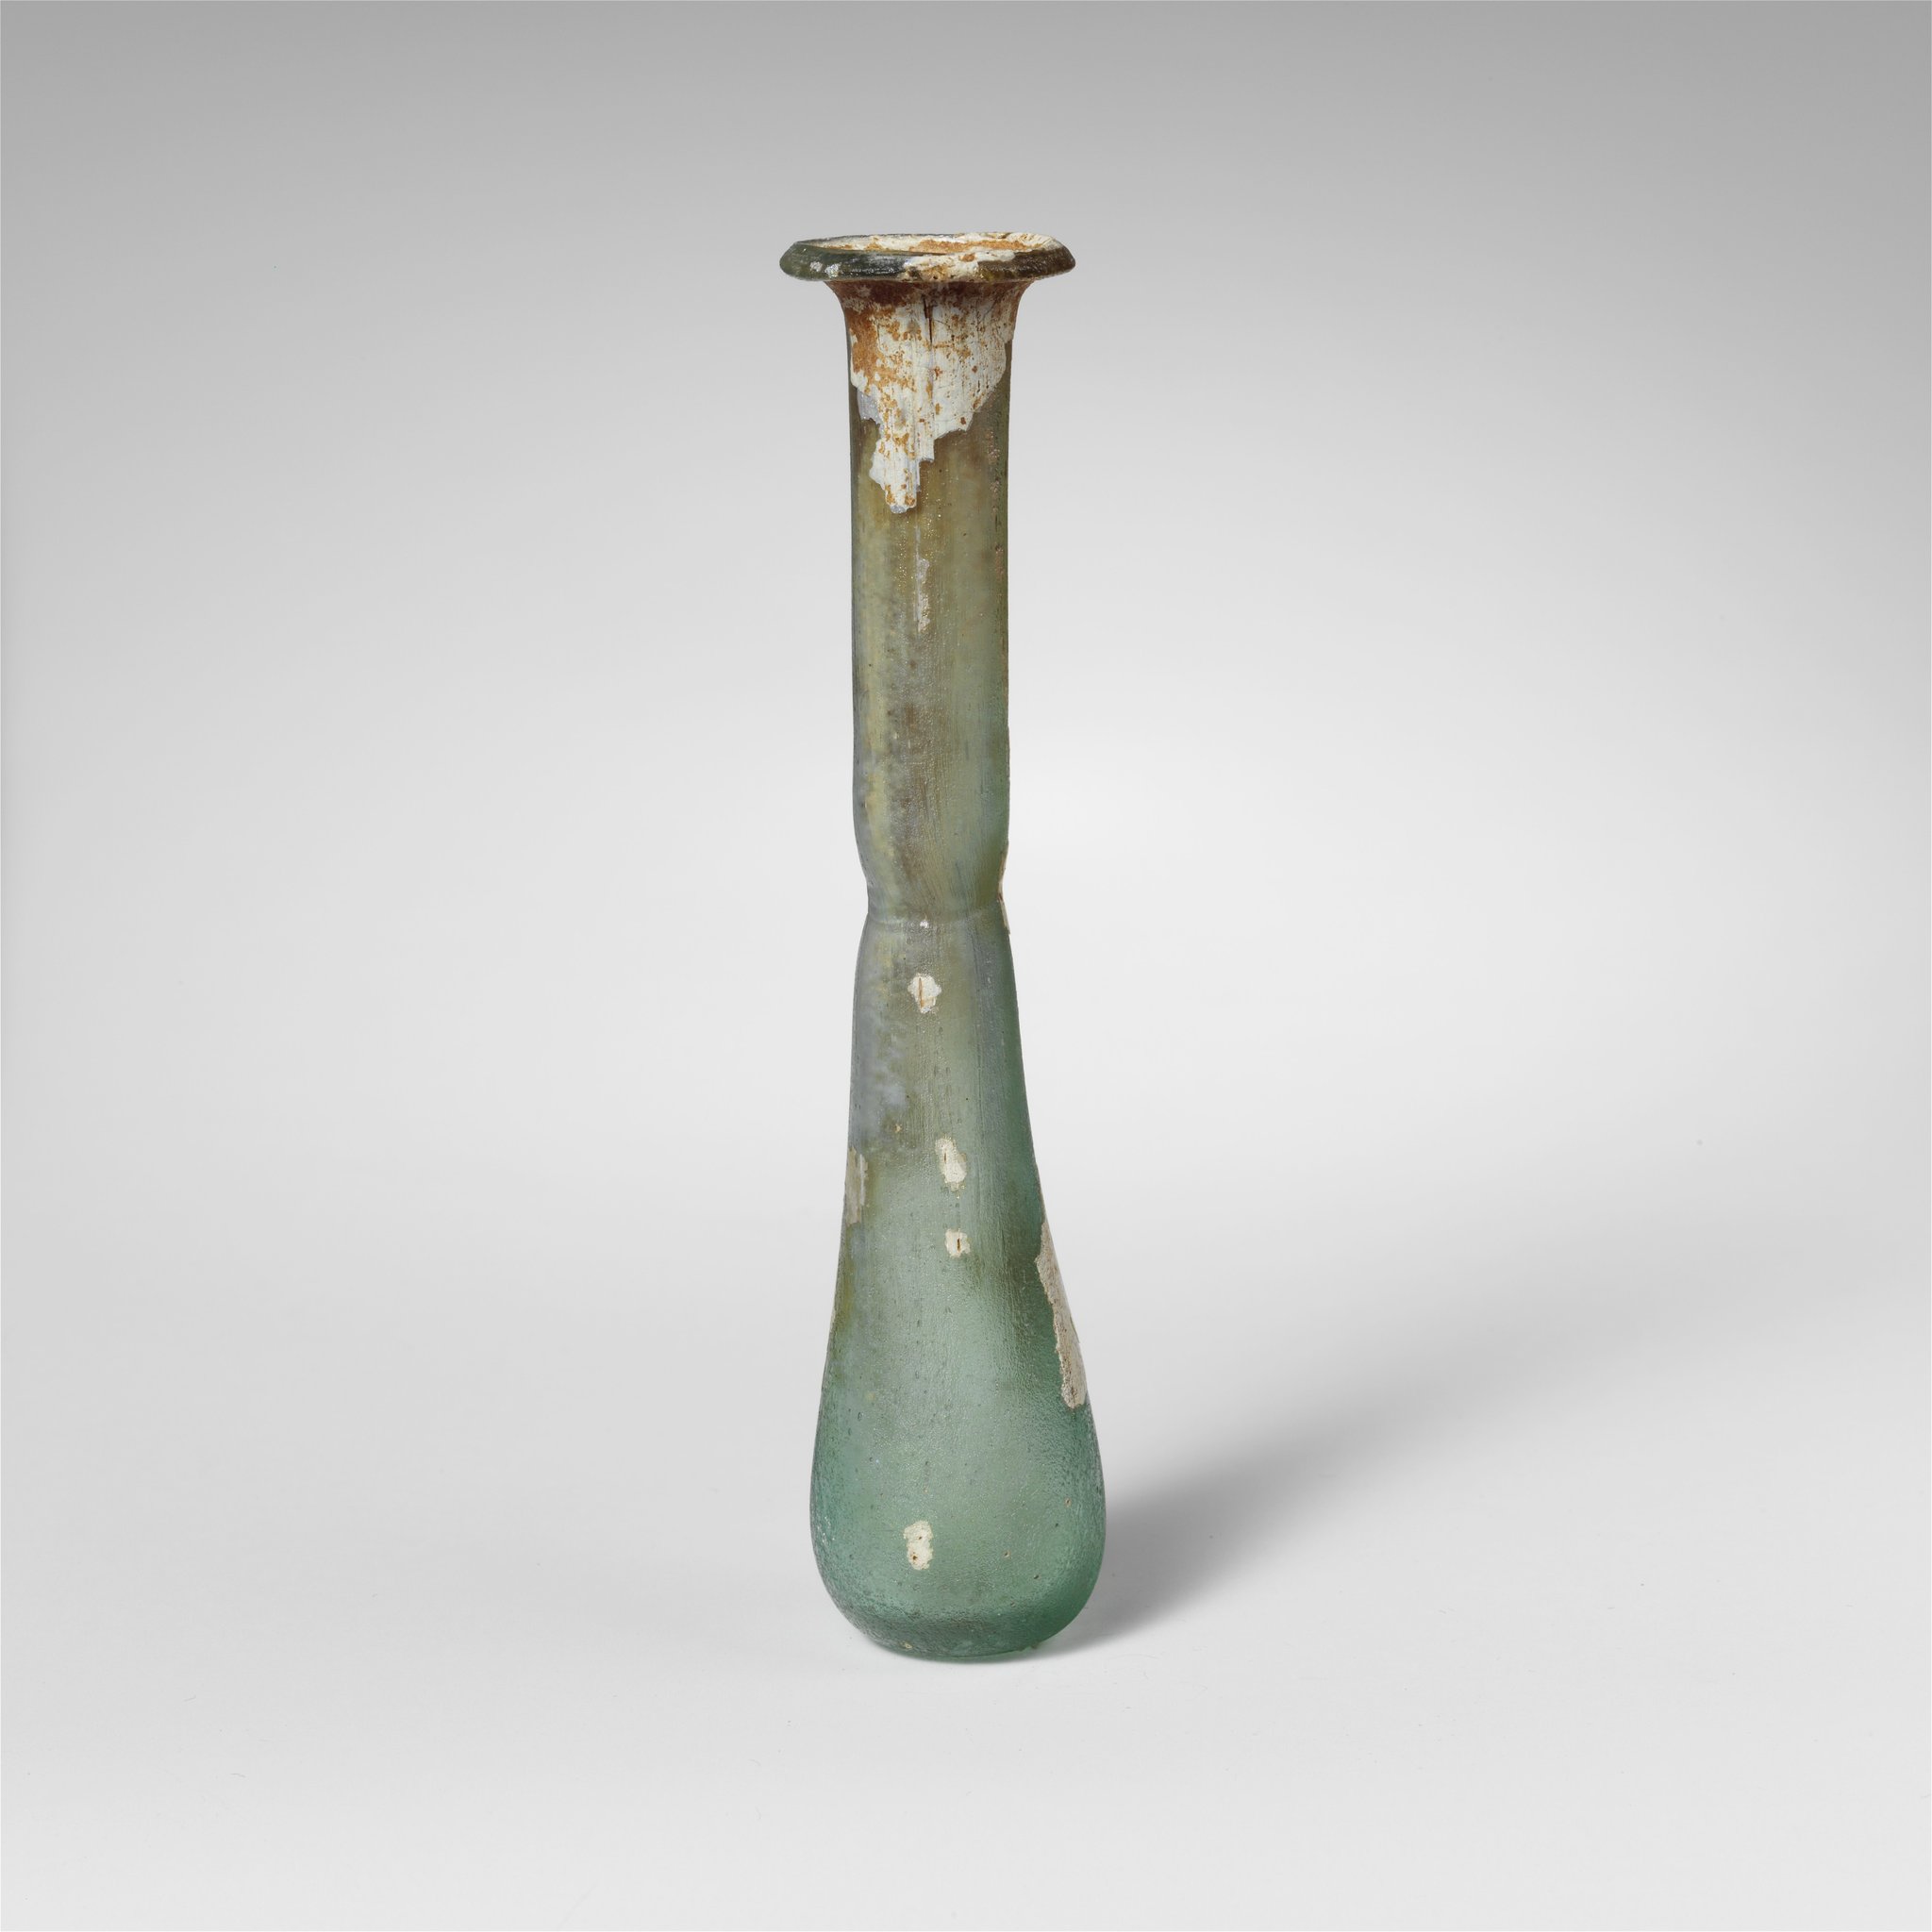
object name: perfume bottle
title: Glass perfume bottle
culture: roman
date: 1-200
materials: glass